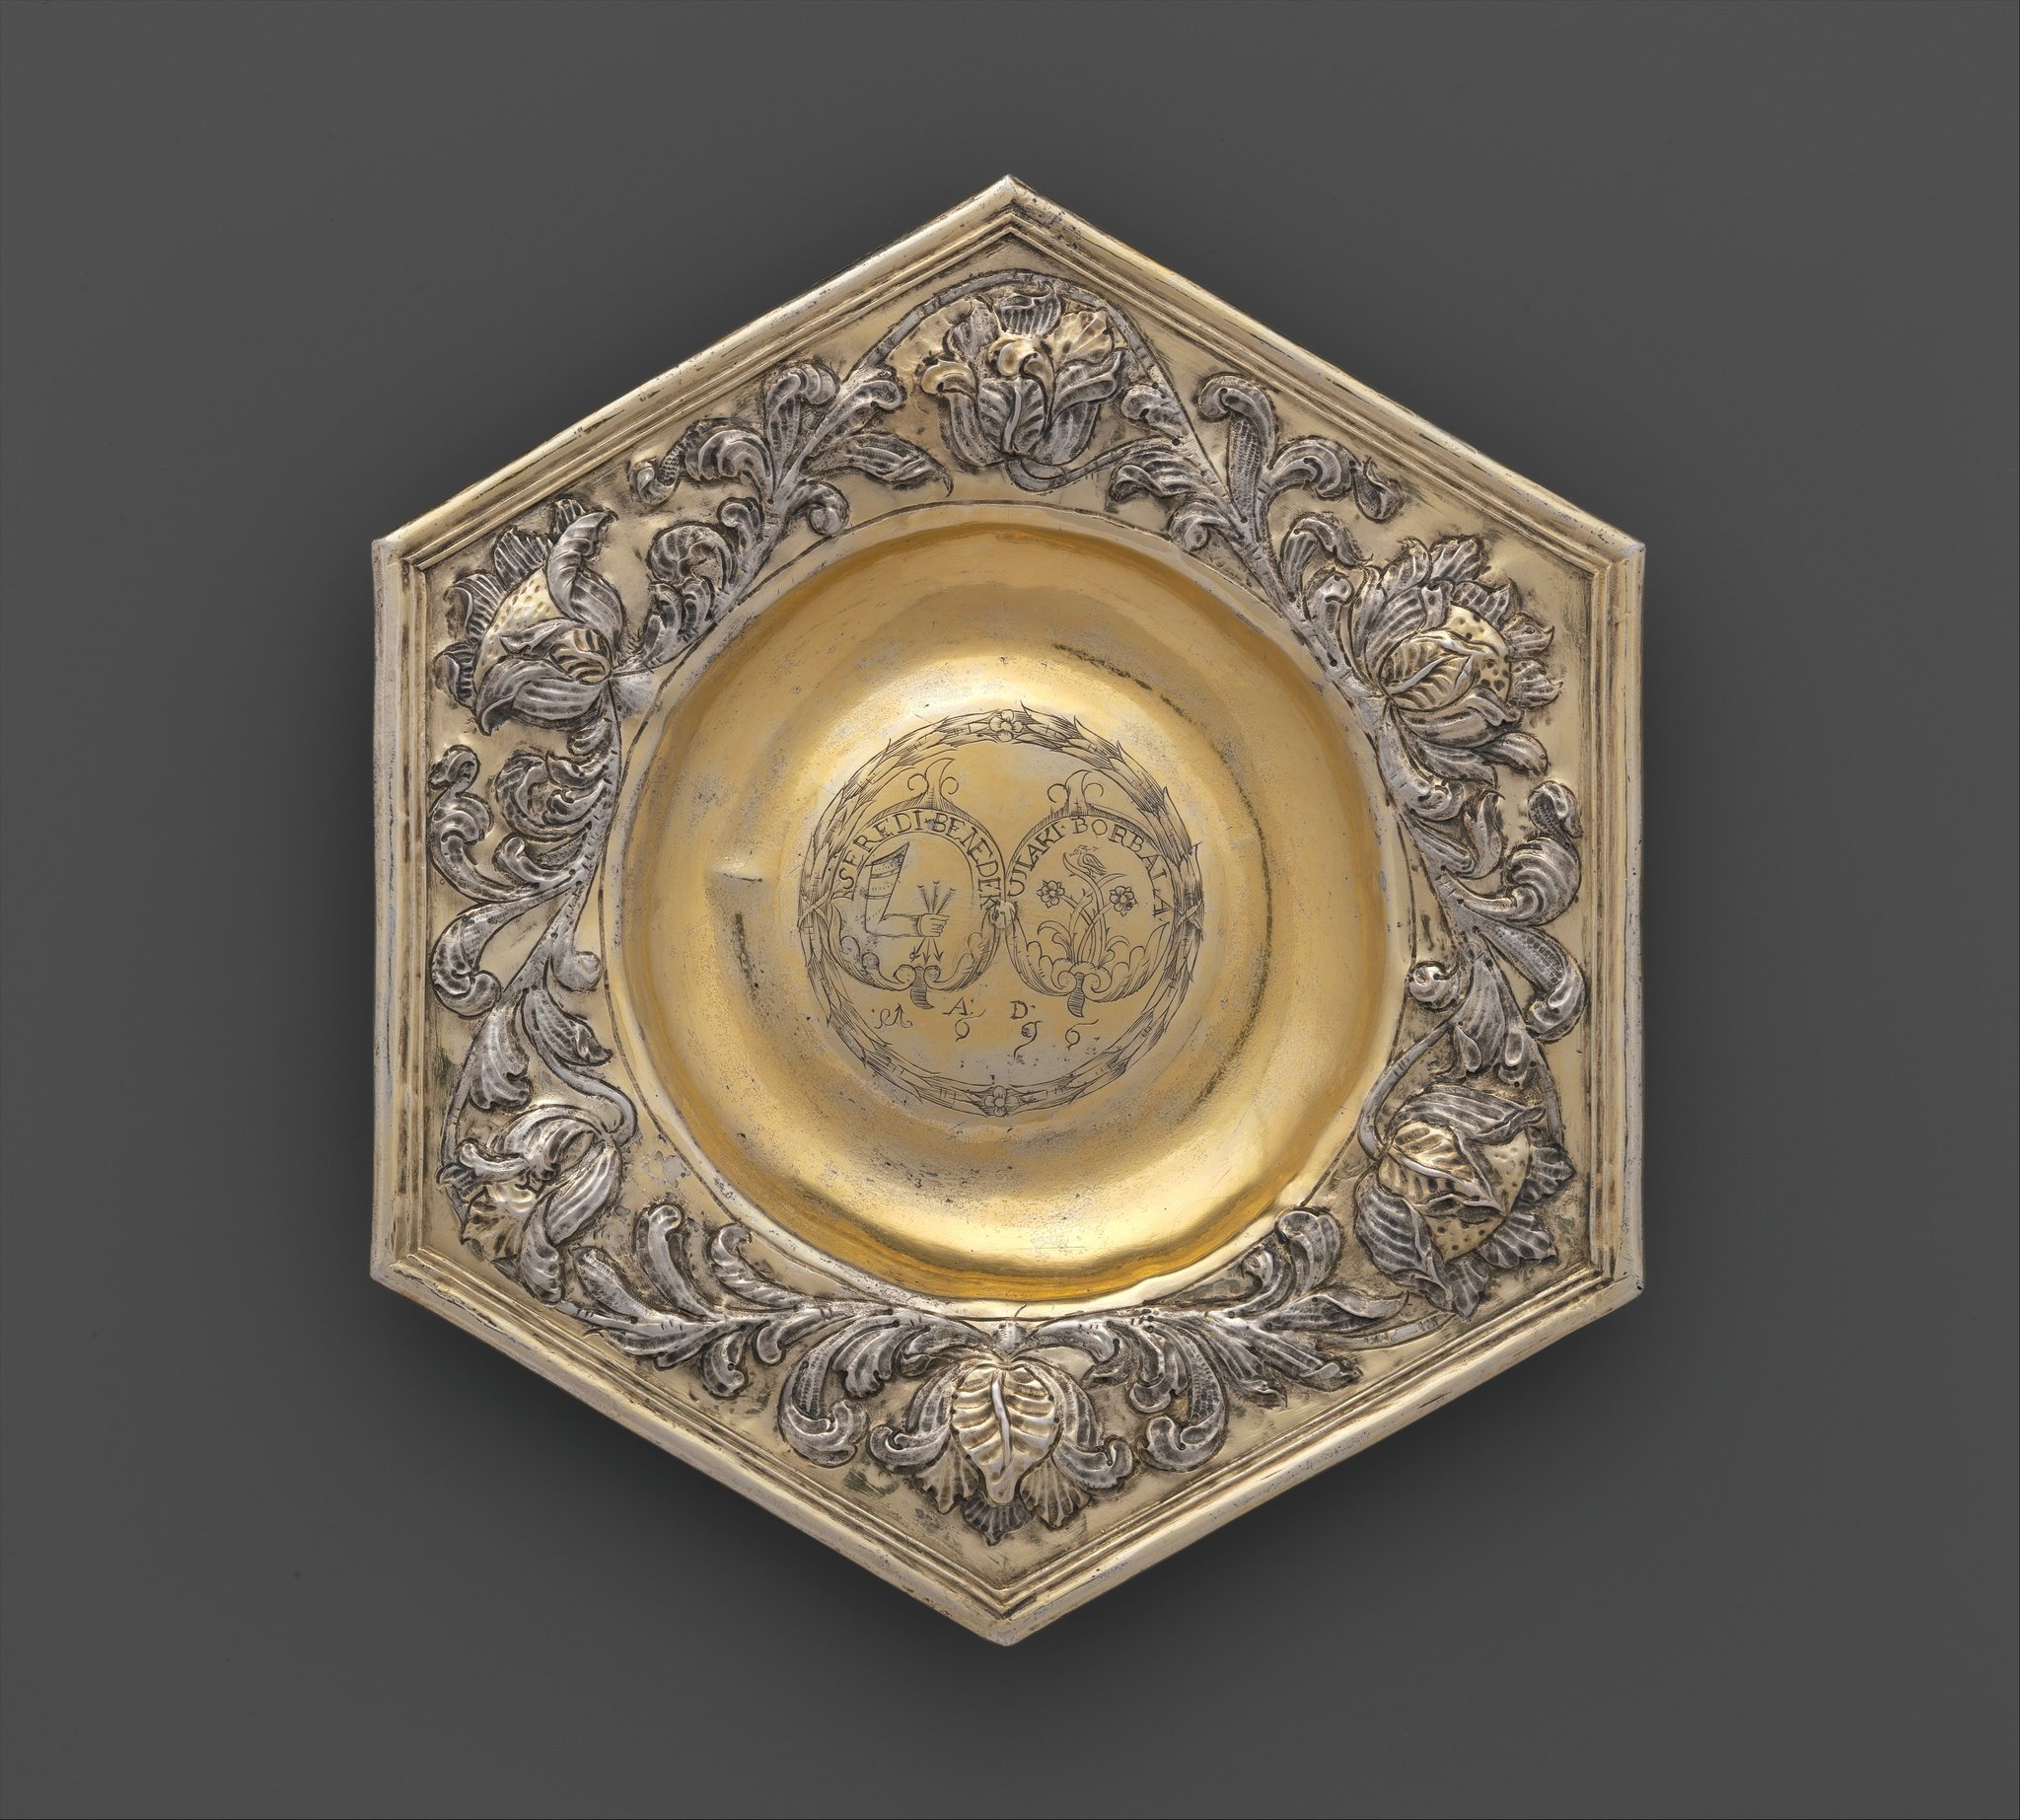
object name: dish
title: Hexagonal dish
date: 1696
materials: silver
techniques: gilding